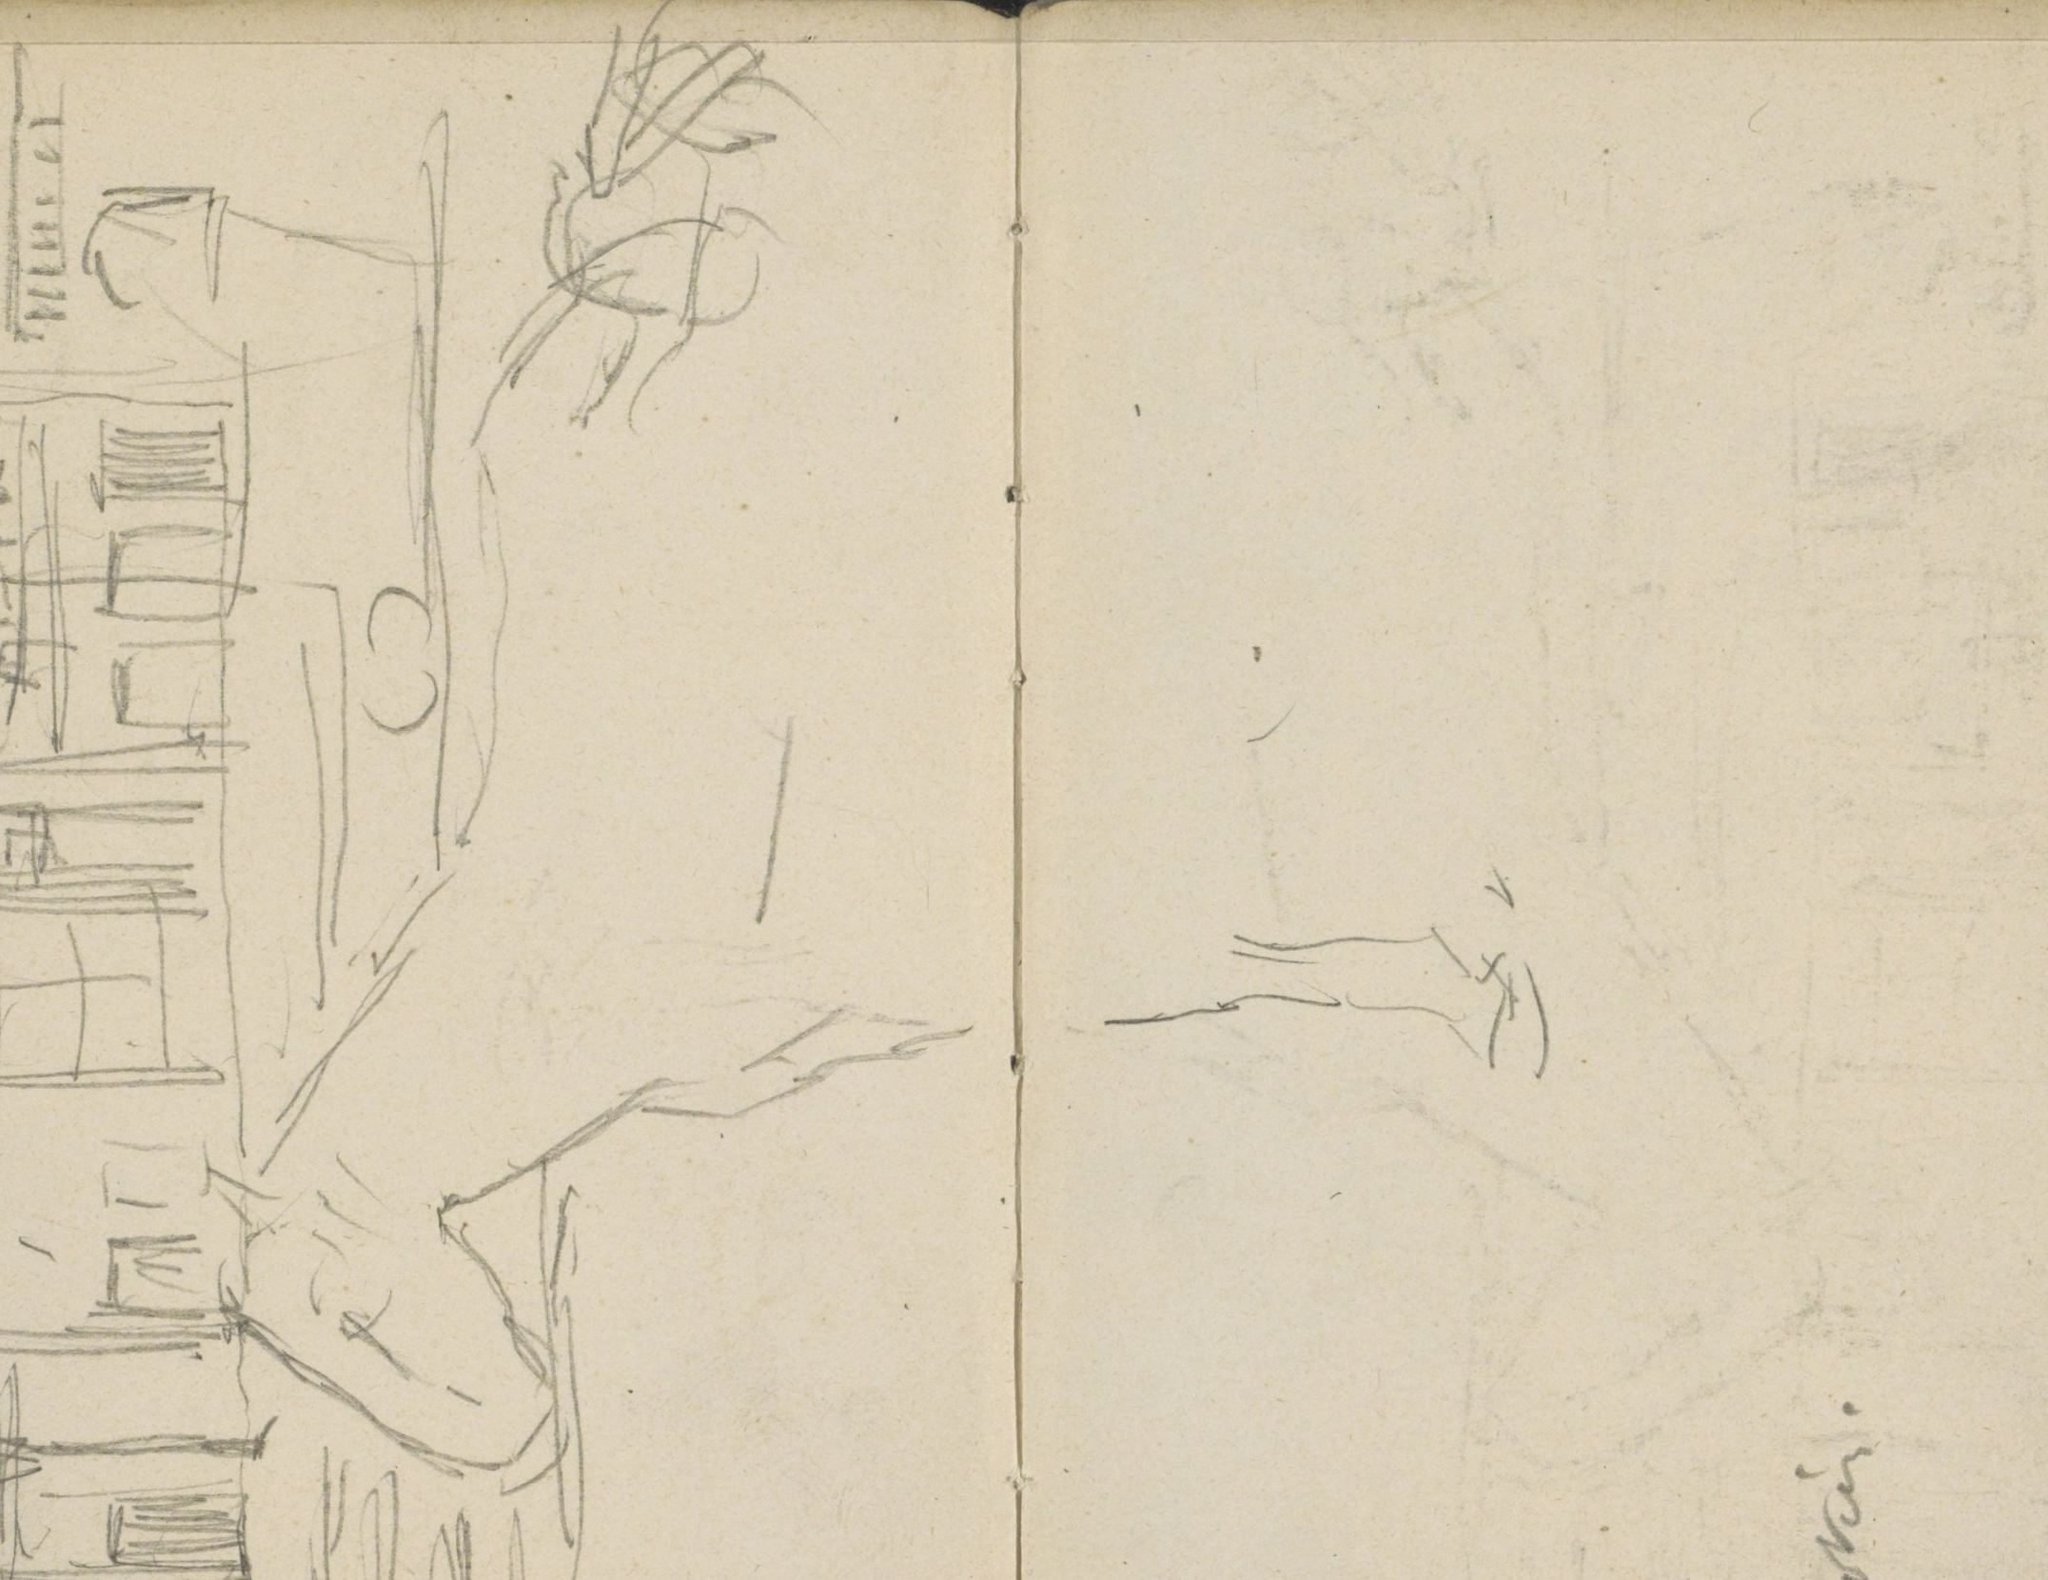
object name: sketchbook leaf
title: Paard op het Rokin te Amsterdam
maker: george hendrik breitner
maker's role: draughtsman, painter, print maker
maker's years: 1857-1923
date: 1903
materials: paper, pencil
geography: amsterdam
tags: urban housing, horse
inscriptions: annotation: ‘Rokin’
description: Paard op het Rokin te Amsterdam. Pagina 5 en pagina 6 uit een schetsboek met 46 bladen vervaardigd te Amsterdam en Haarlem.